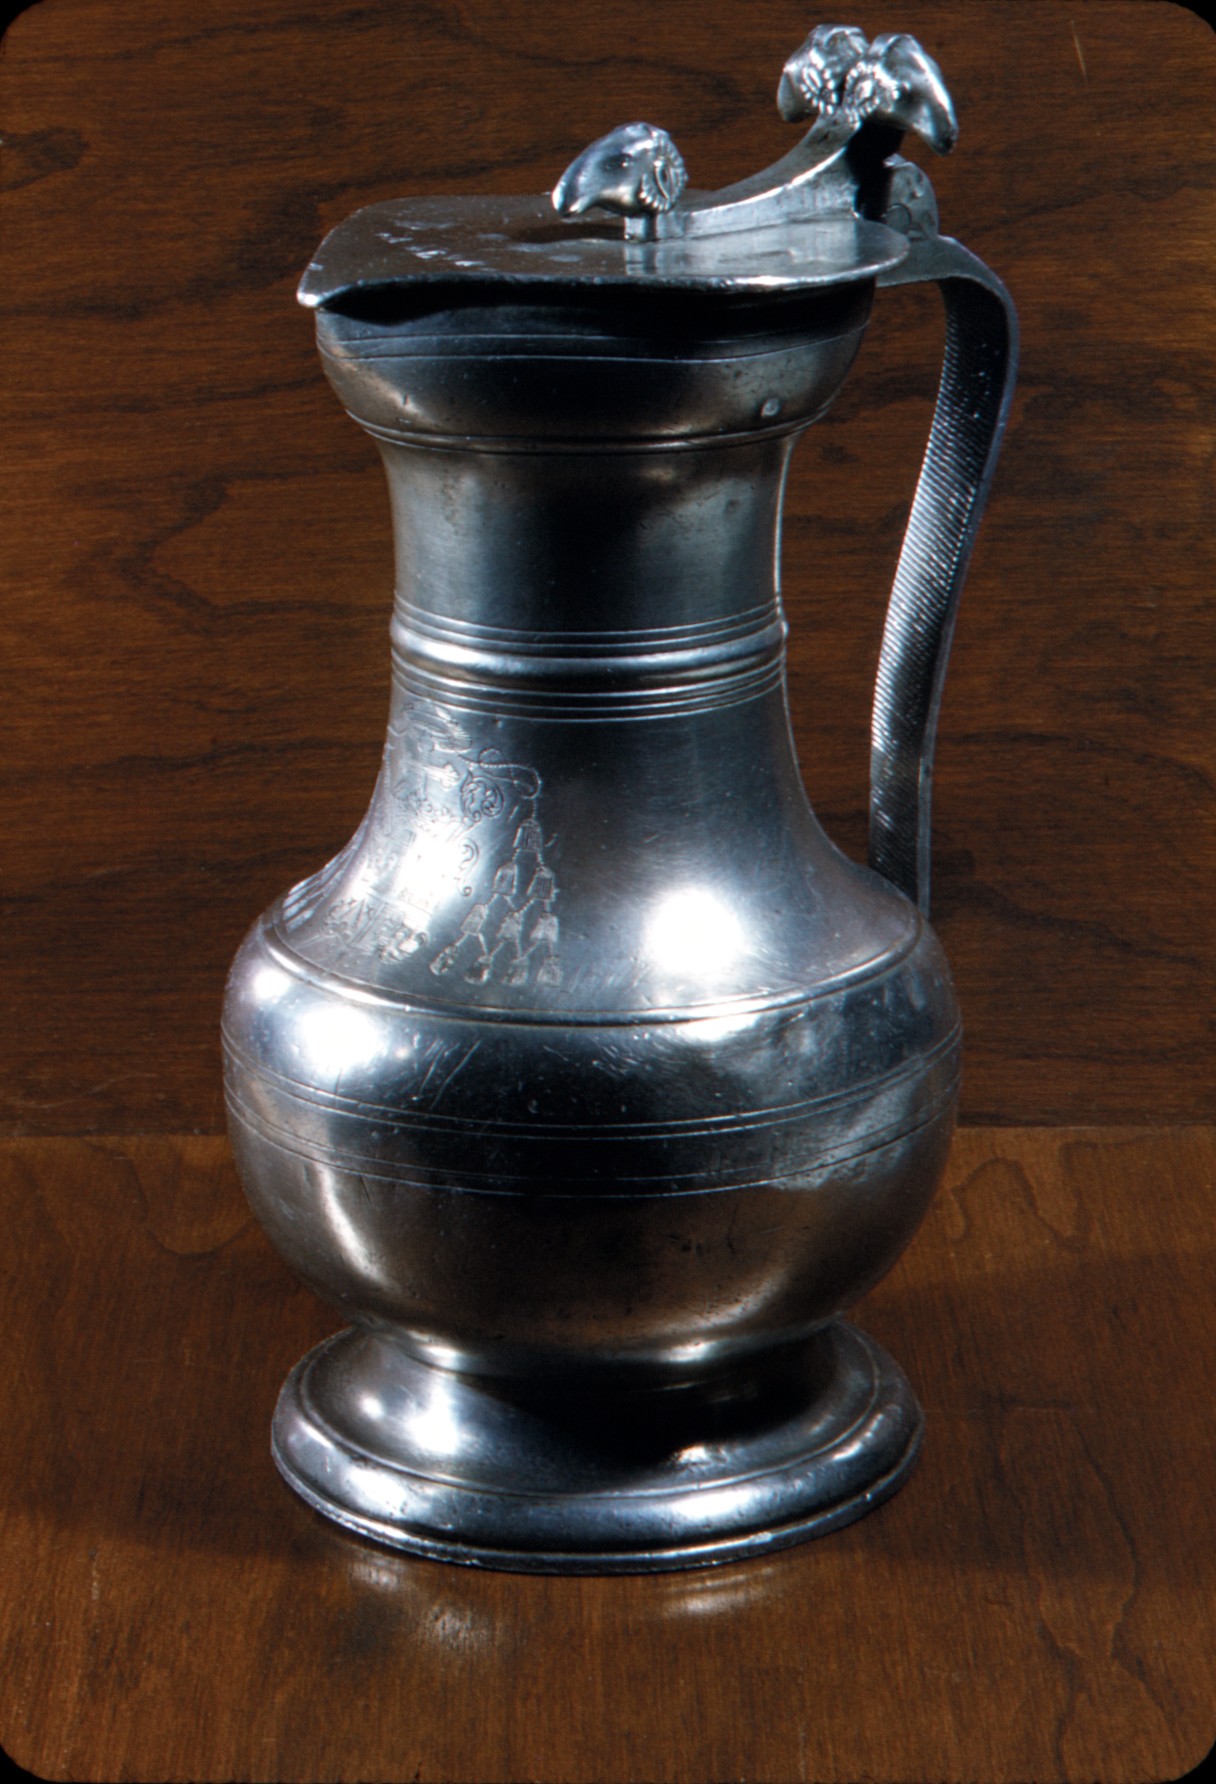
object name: flagon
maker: i. b. (the pewterer)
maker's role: maker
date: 1701-1800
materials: pewter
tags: animals